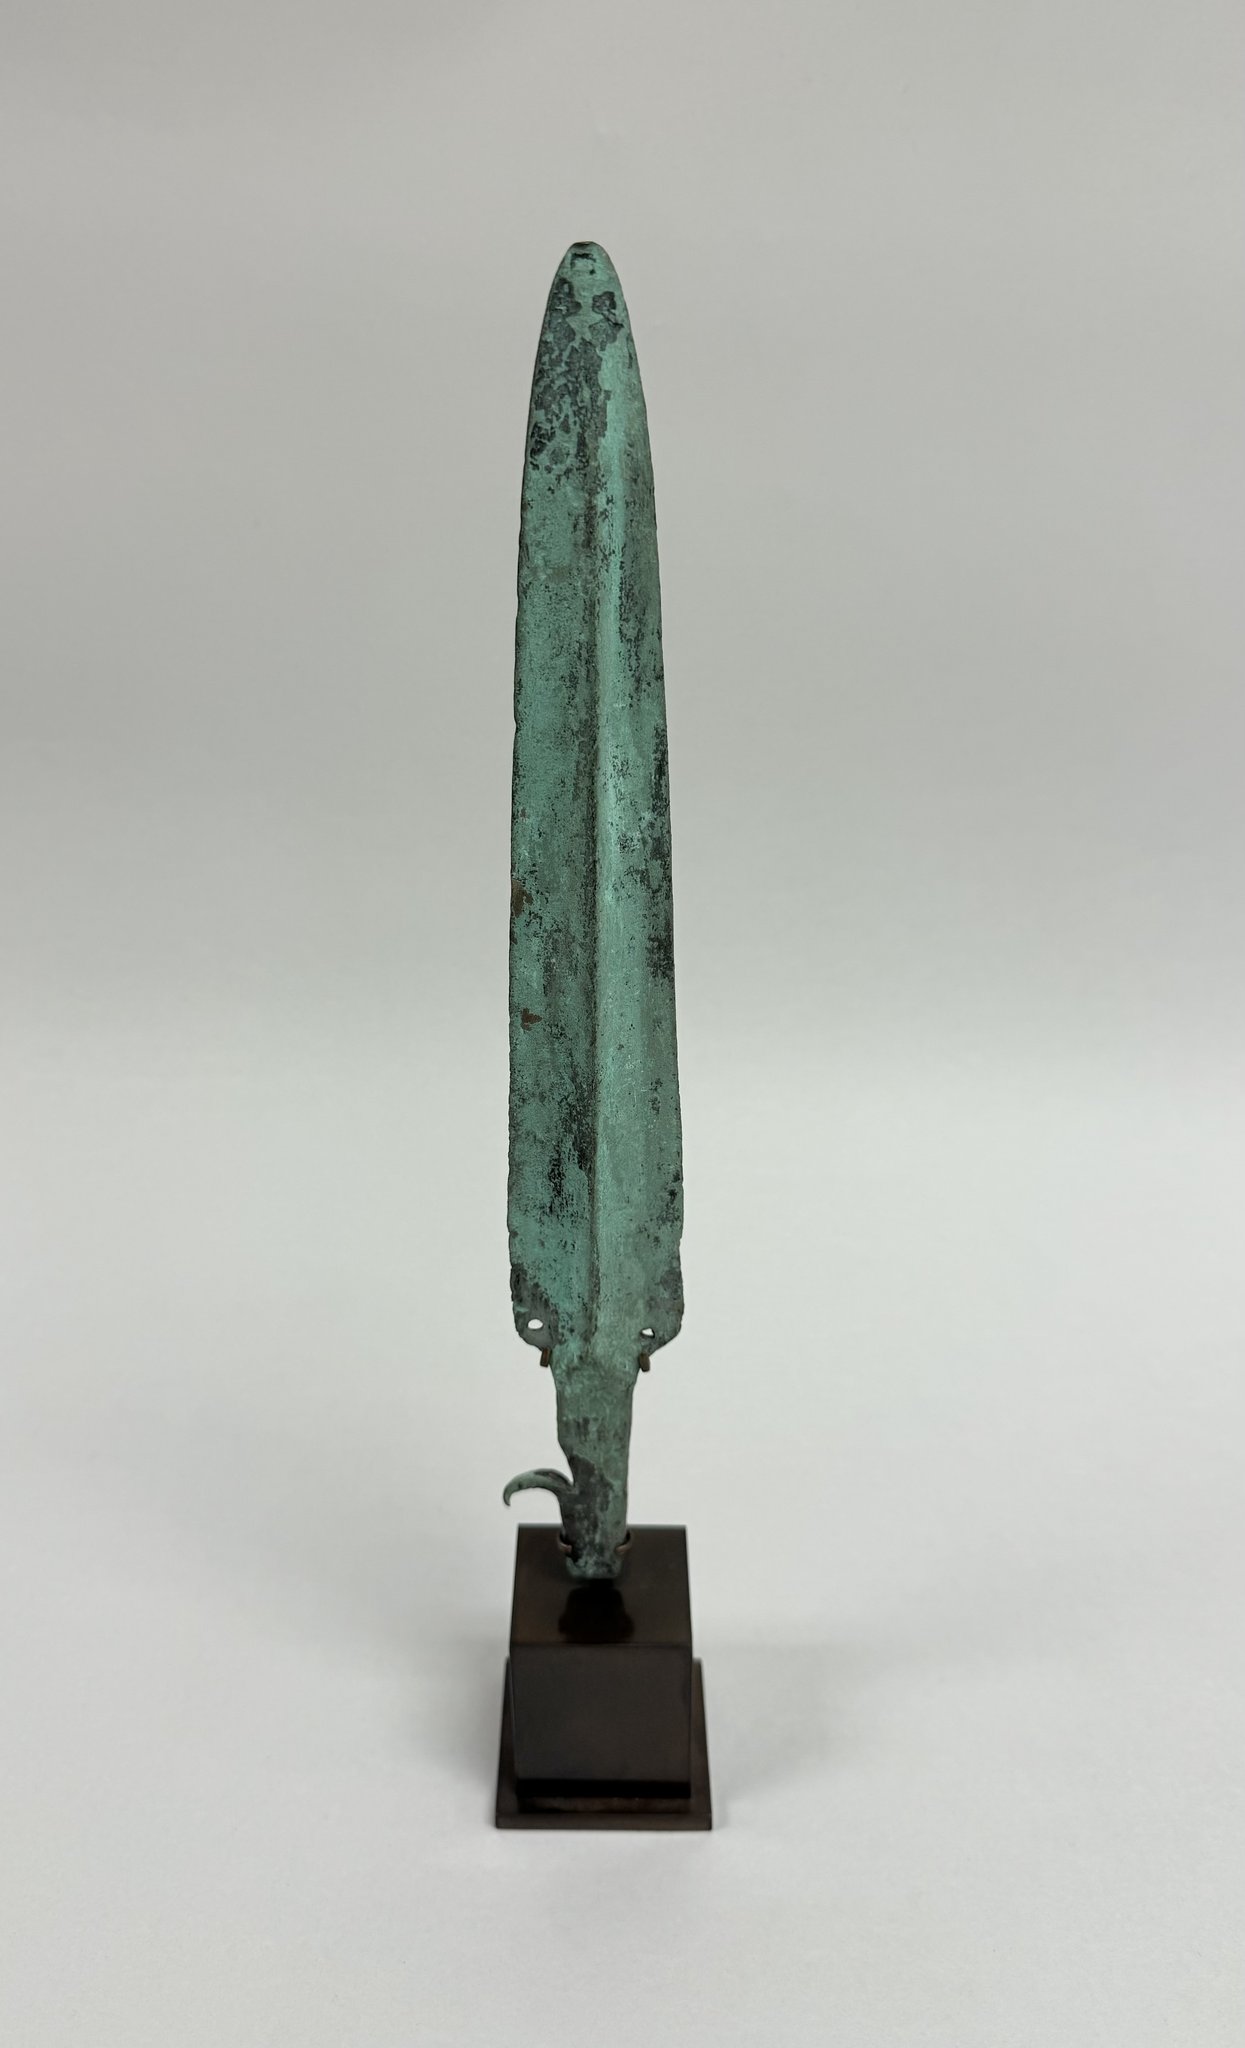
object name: lance head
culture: indian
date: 1500-500 BCE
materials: copper